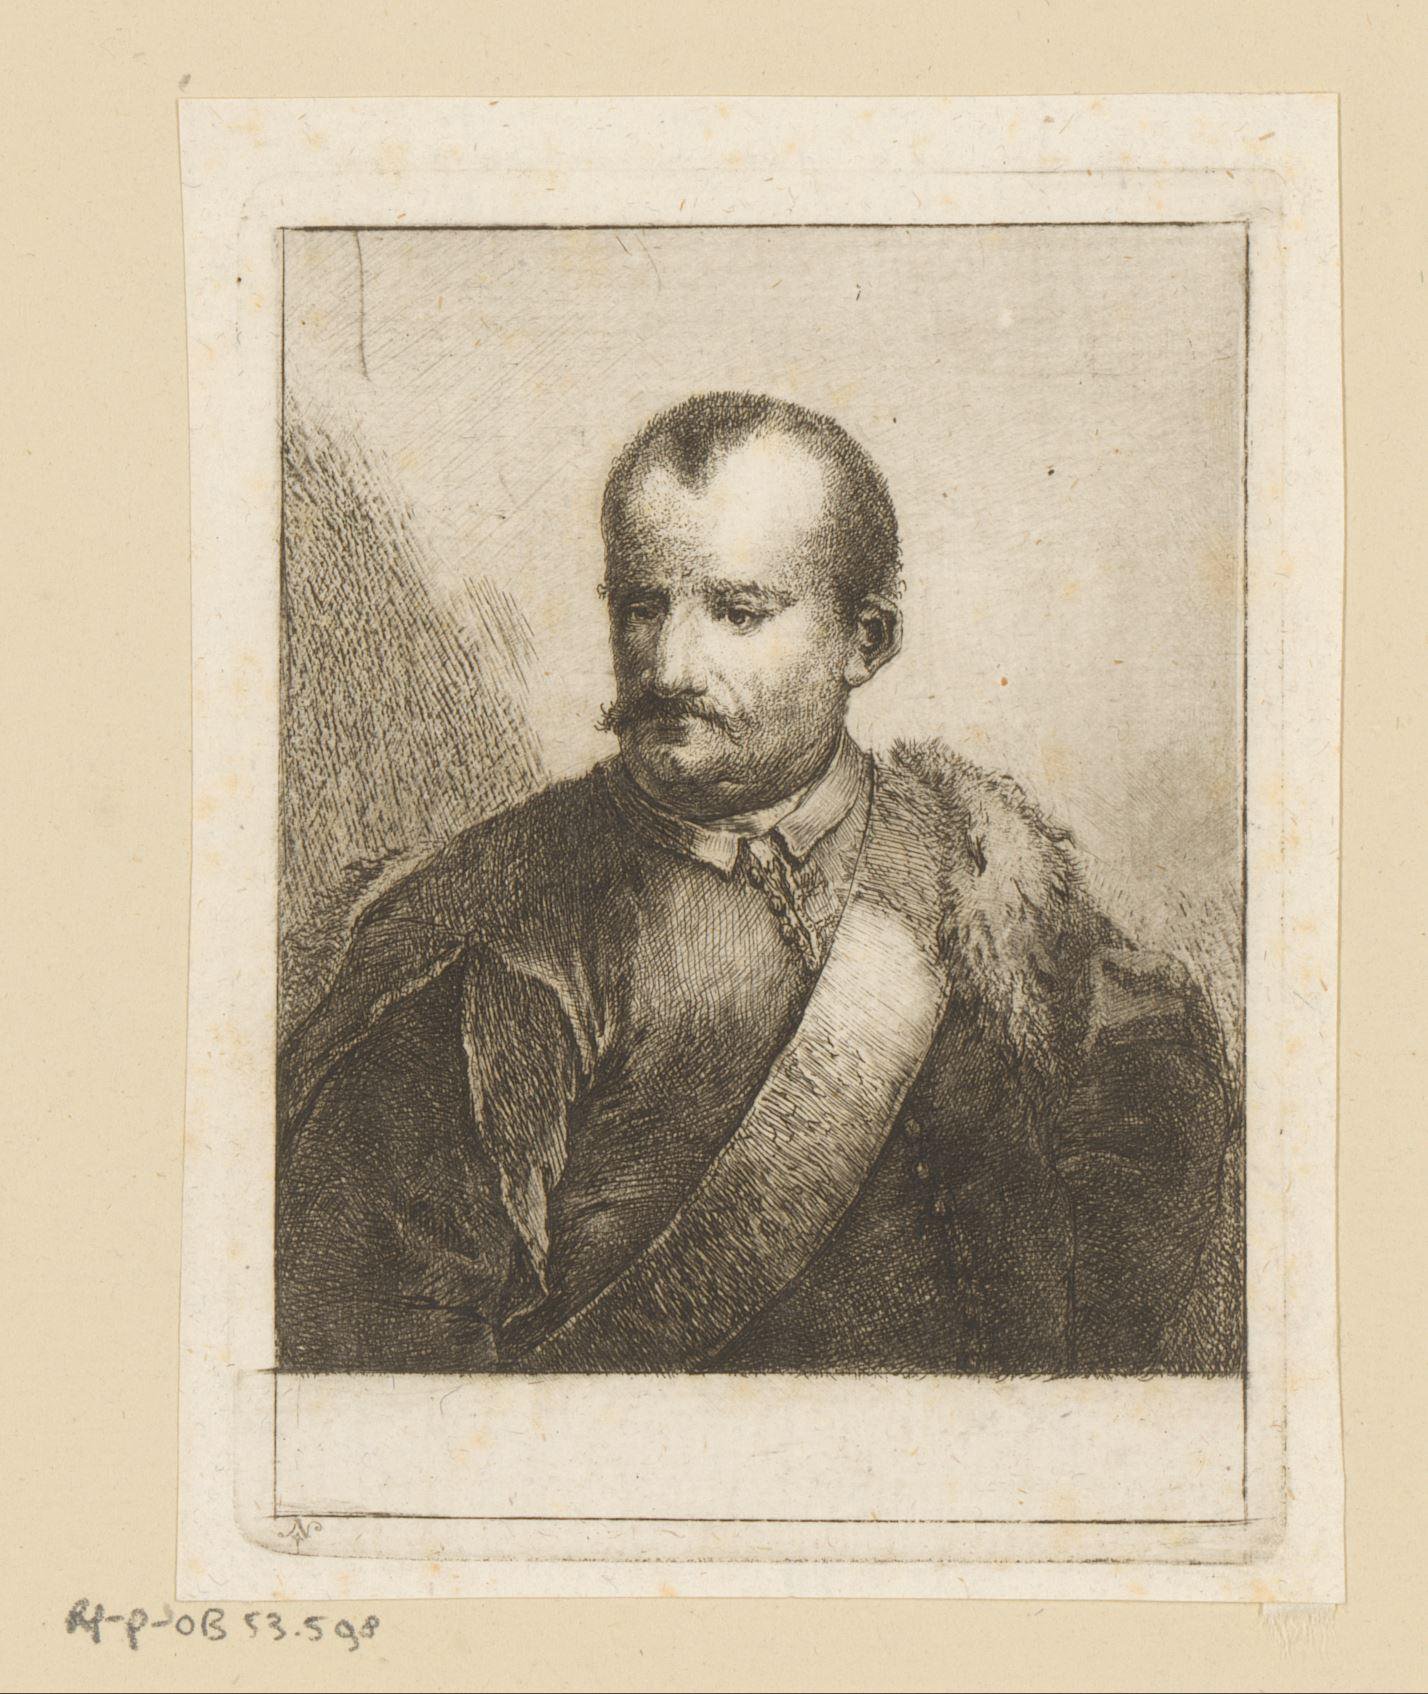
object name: print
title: Portret van Radziwill, prins van Polen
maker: johann andreas benjamin nothnagel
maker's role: print maker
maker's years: 1729-1804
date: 1739-1804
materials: paper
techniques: etching, intaglio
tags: historical persons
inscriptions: collector's mark: Lugt 240